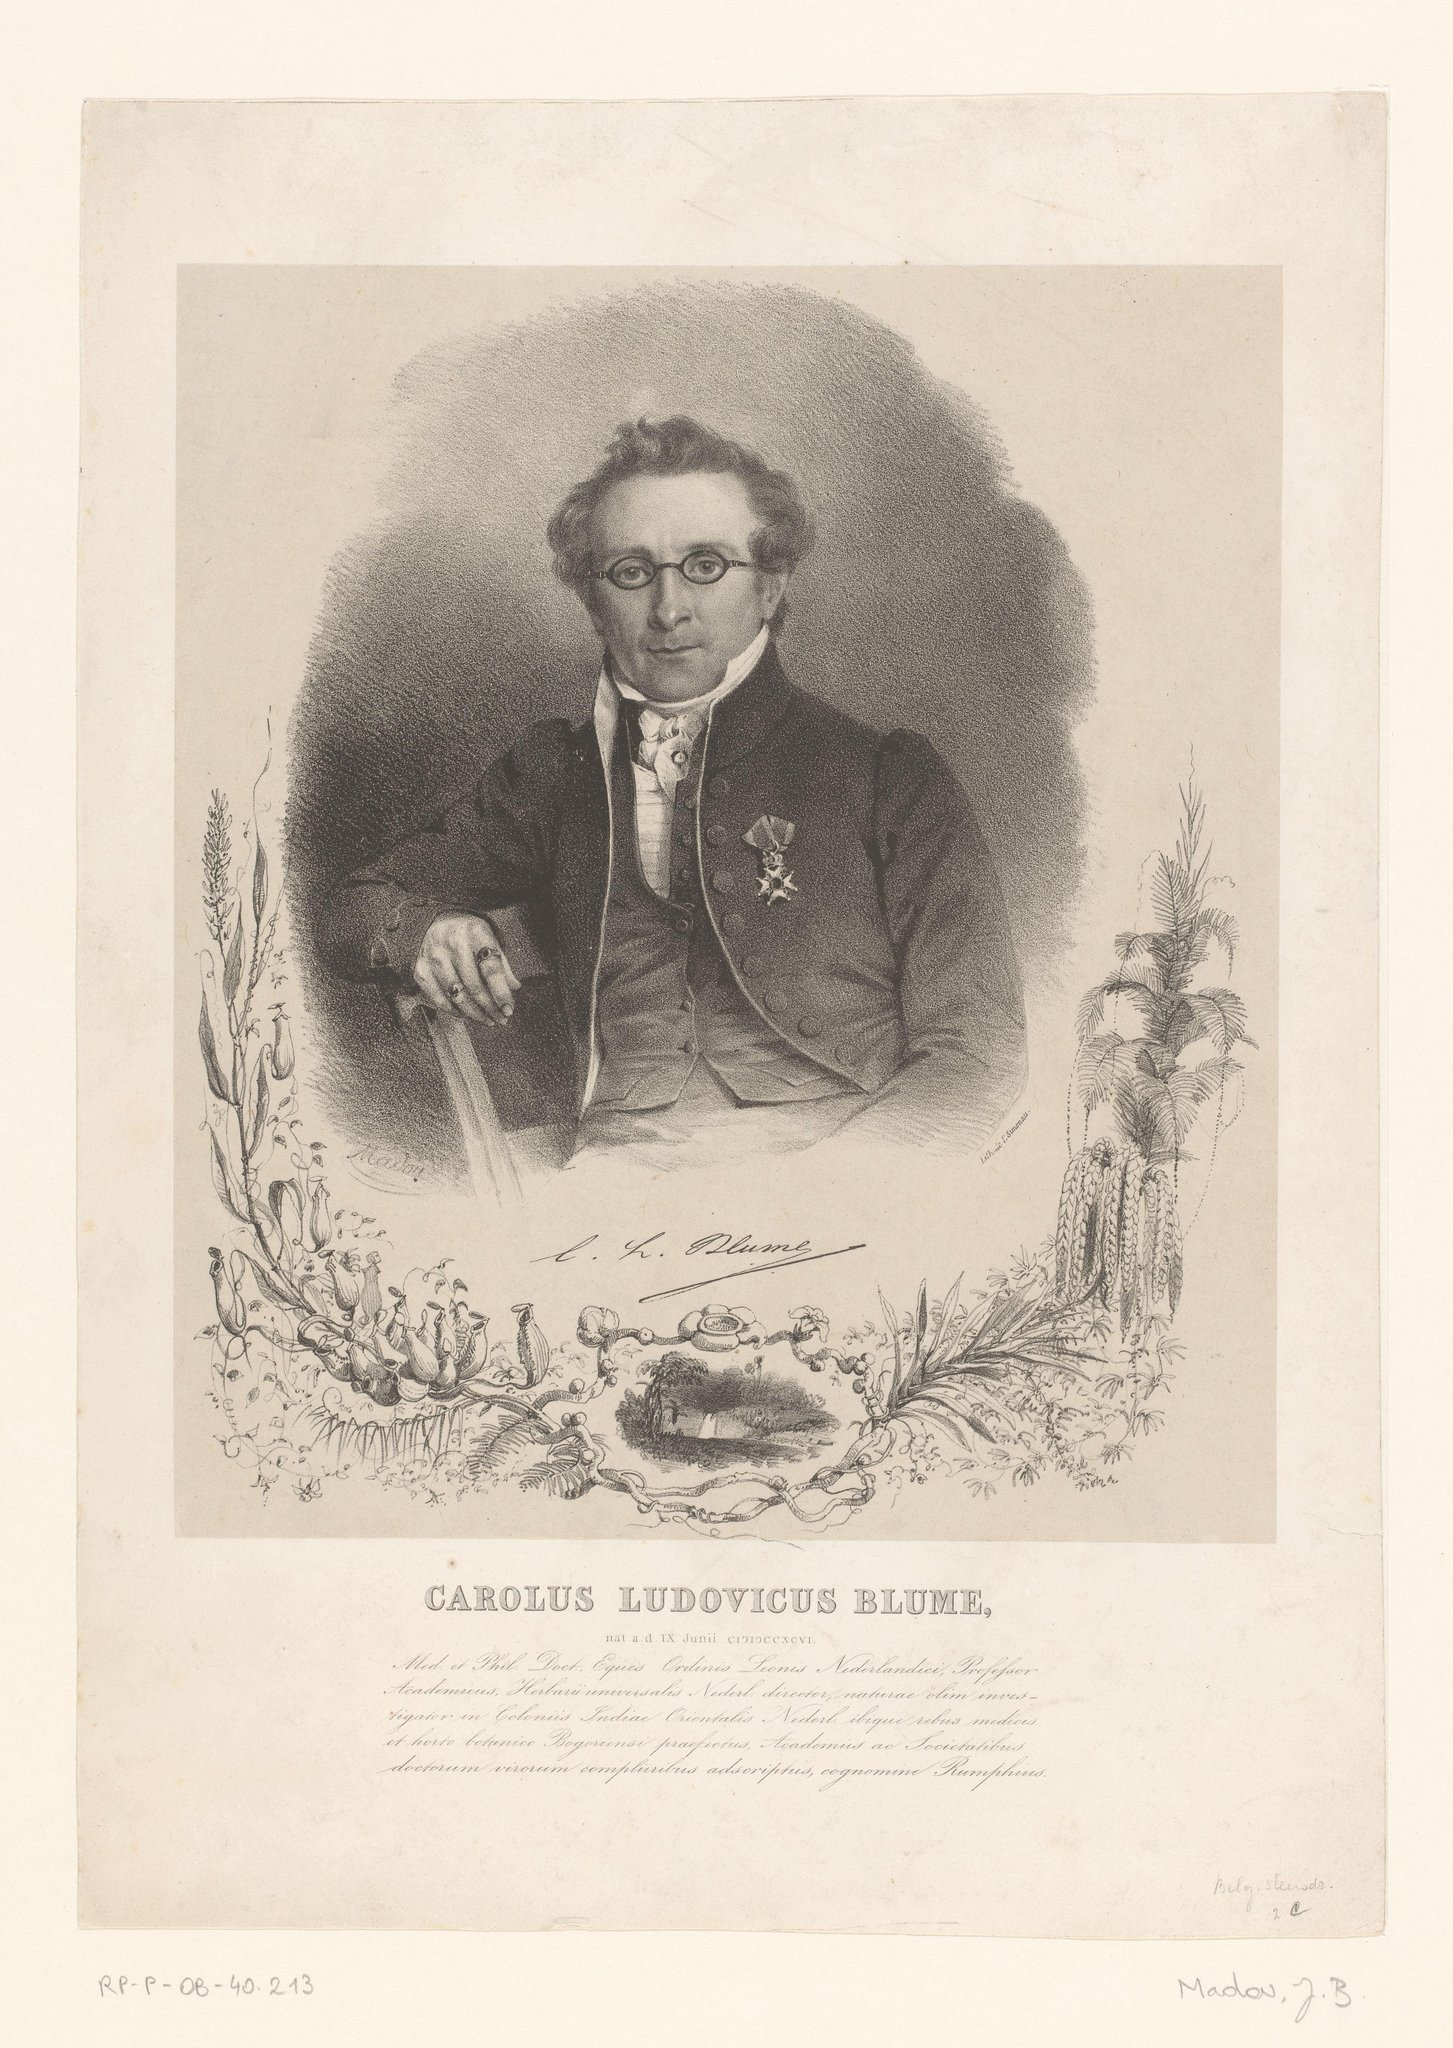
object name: print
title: Portret van Carl Ludwig Blume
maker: pierre simonau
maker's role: printer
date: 1828-1835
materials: paper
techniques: lithograph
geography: brussels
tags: eyeglasses, spectacles, adult man, historical persons, foliage, tendrils, branches ~ ornament